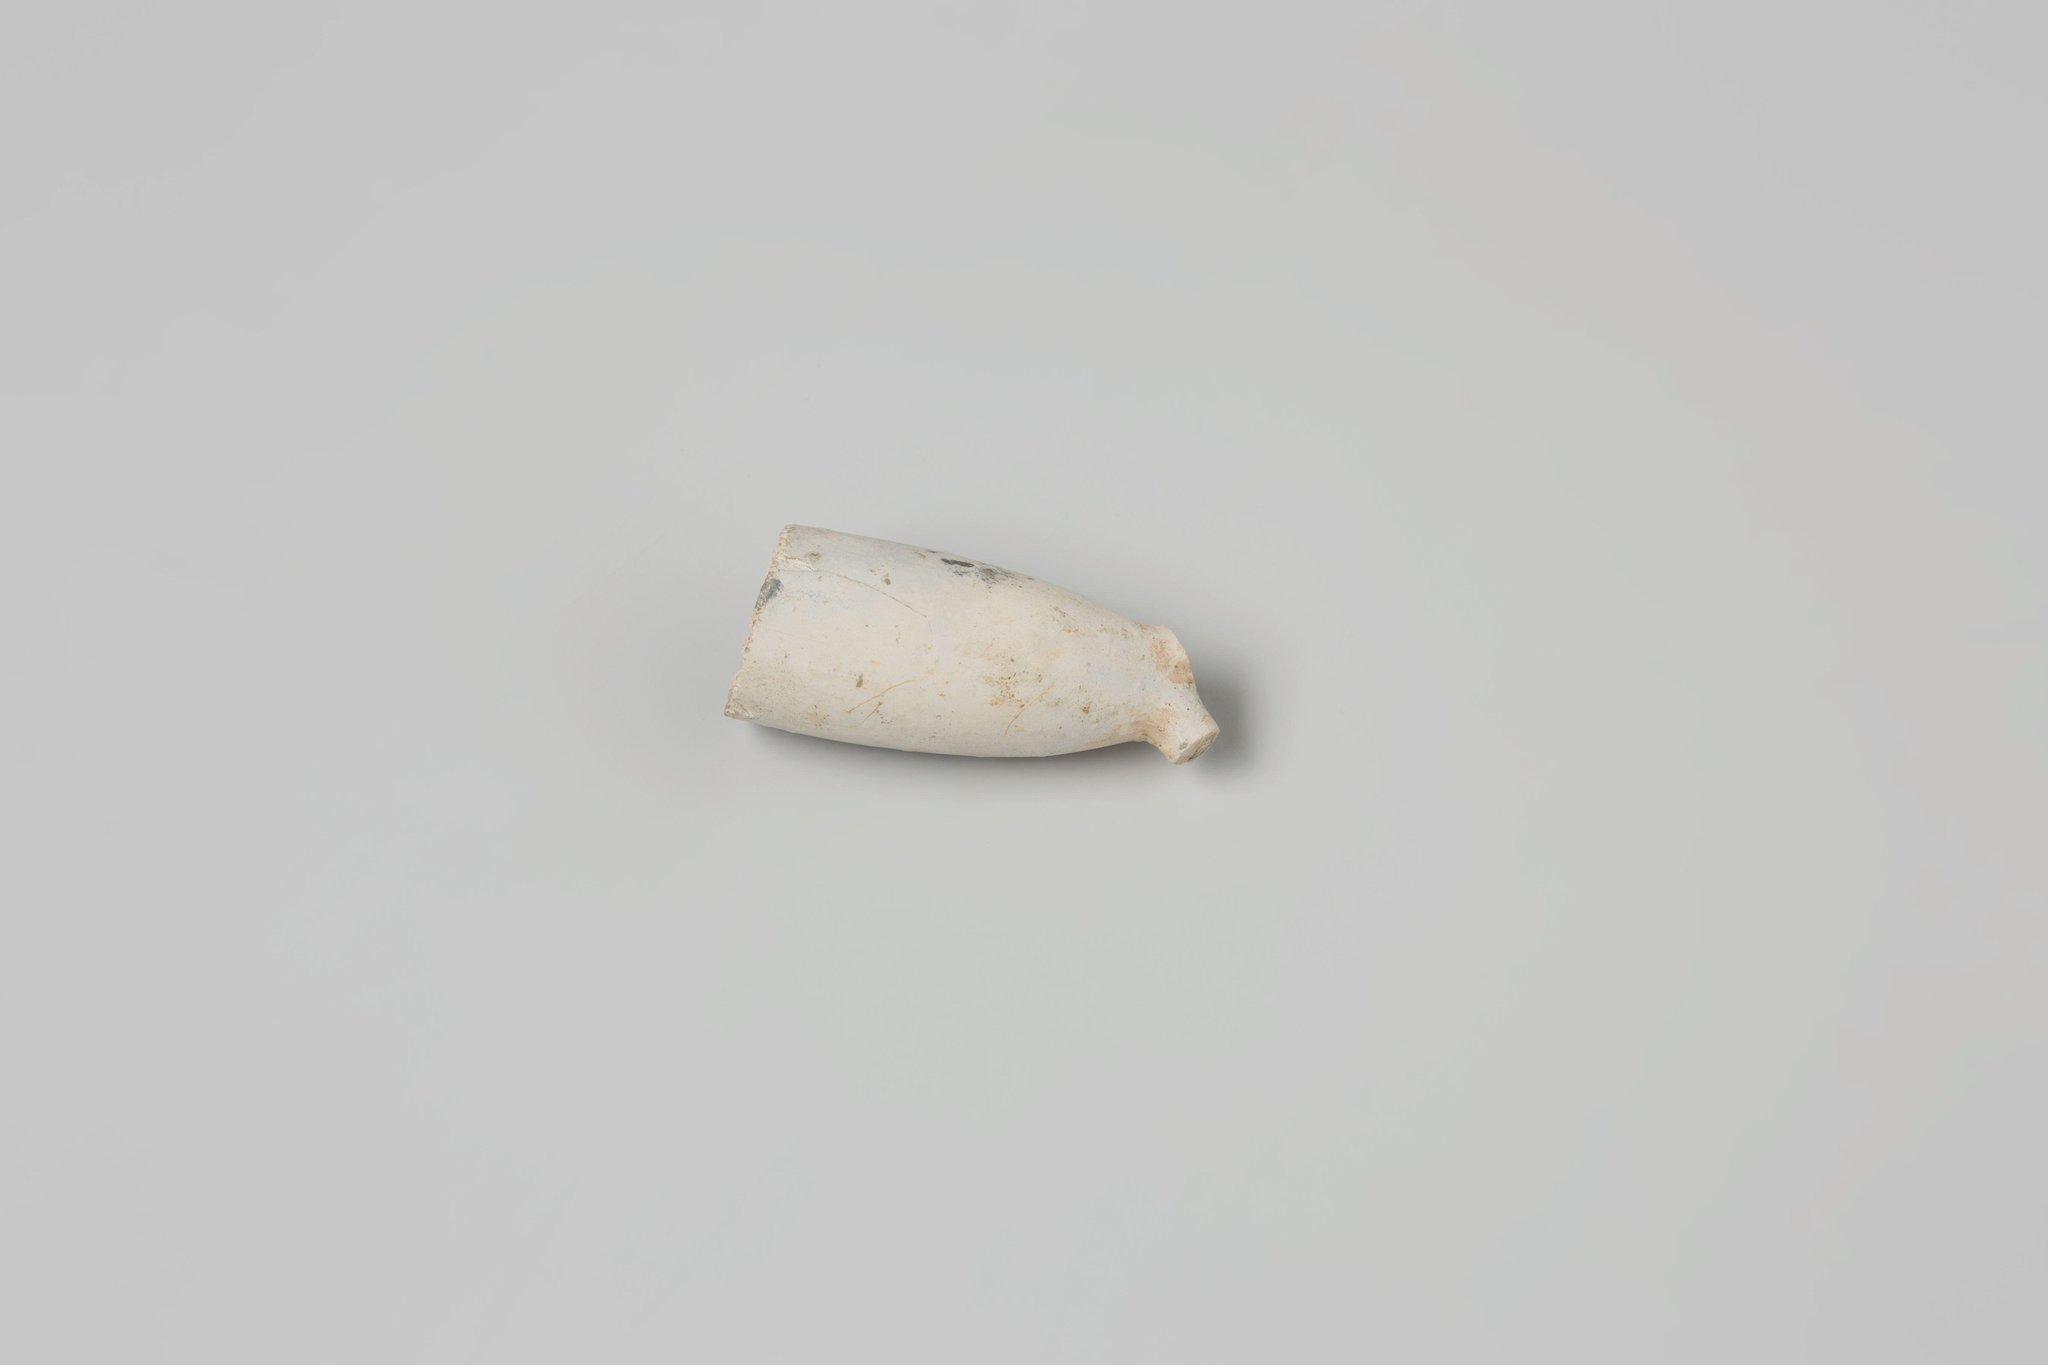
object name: pipe bowl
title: Fragment van een pijpenkop uit het wrak van de Oost-Indiëvaarder 't Vliegend Hart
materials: clay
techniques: firing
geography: gouda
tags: 't vliegend hart (schip), verenigde oostindische compagnie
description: Een kop zonder steel van een aarden Goudse pijp, blauw-wit gelig van kleur. Hielmerk WS. Licht beschadigd. Fragments of bowls and stems.